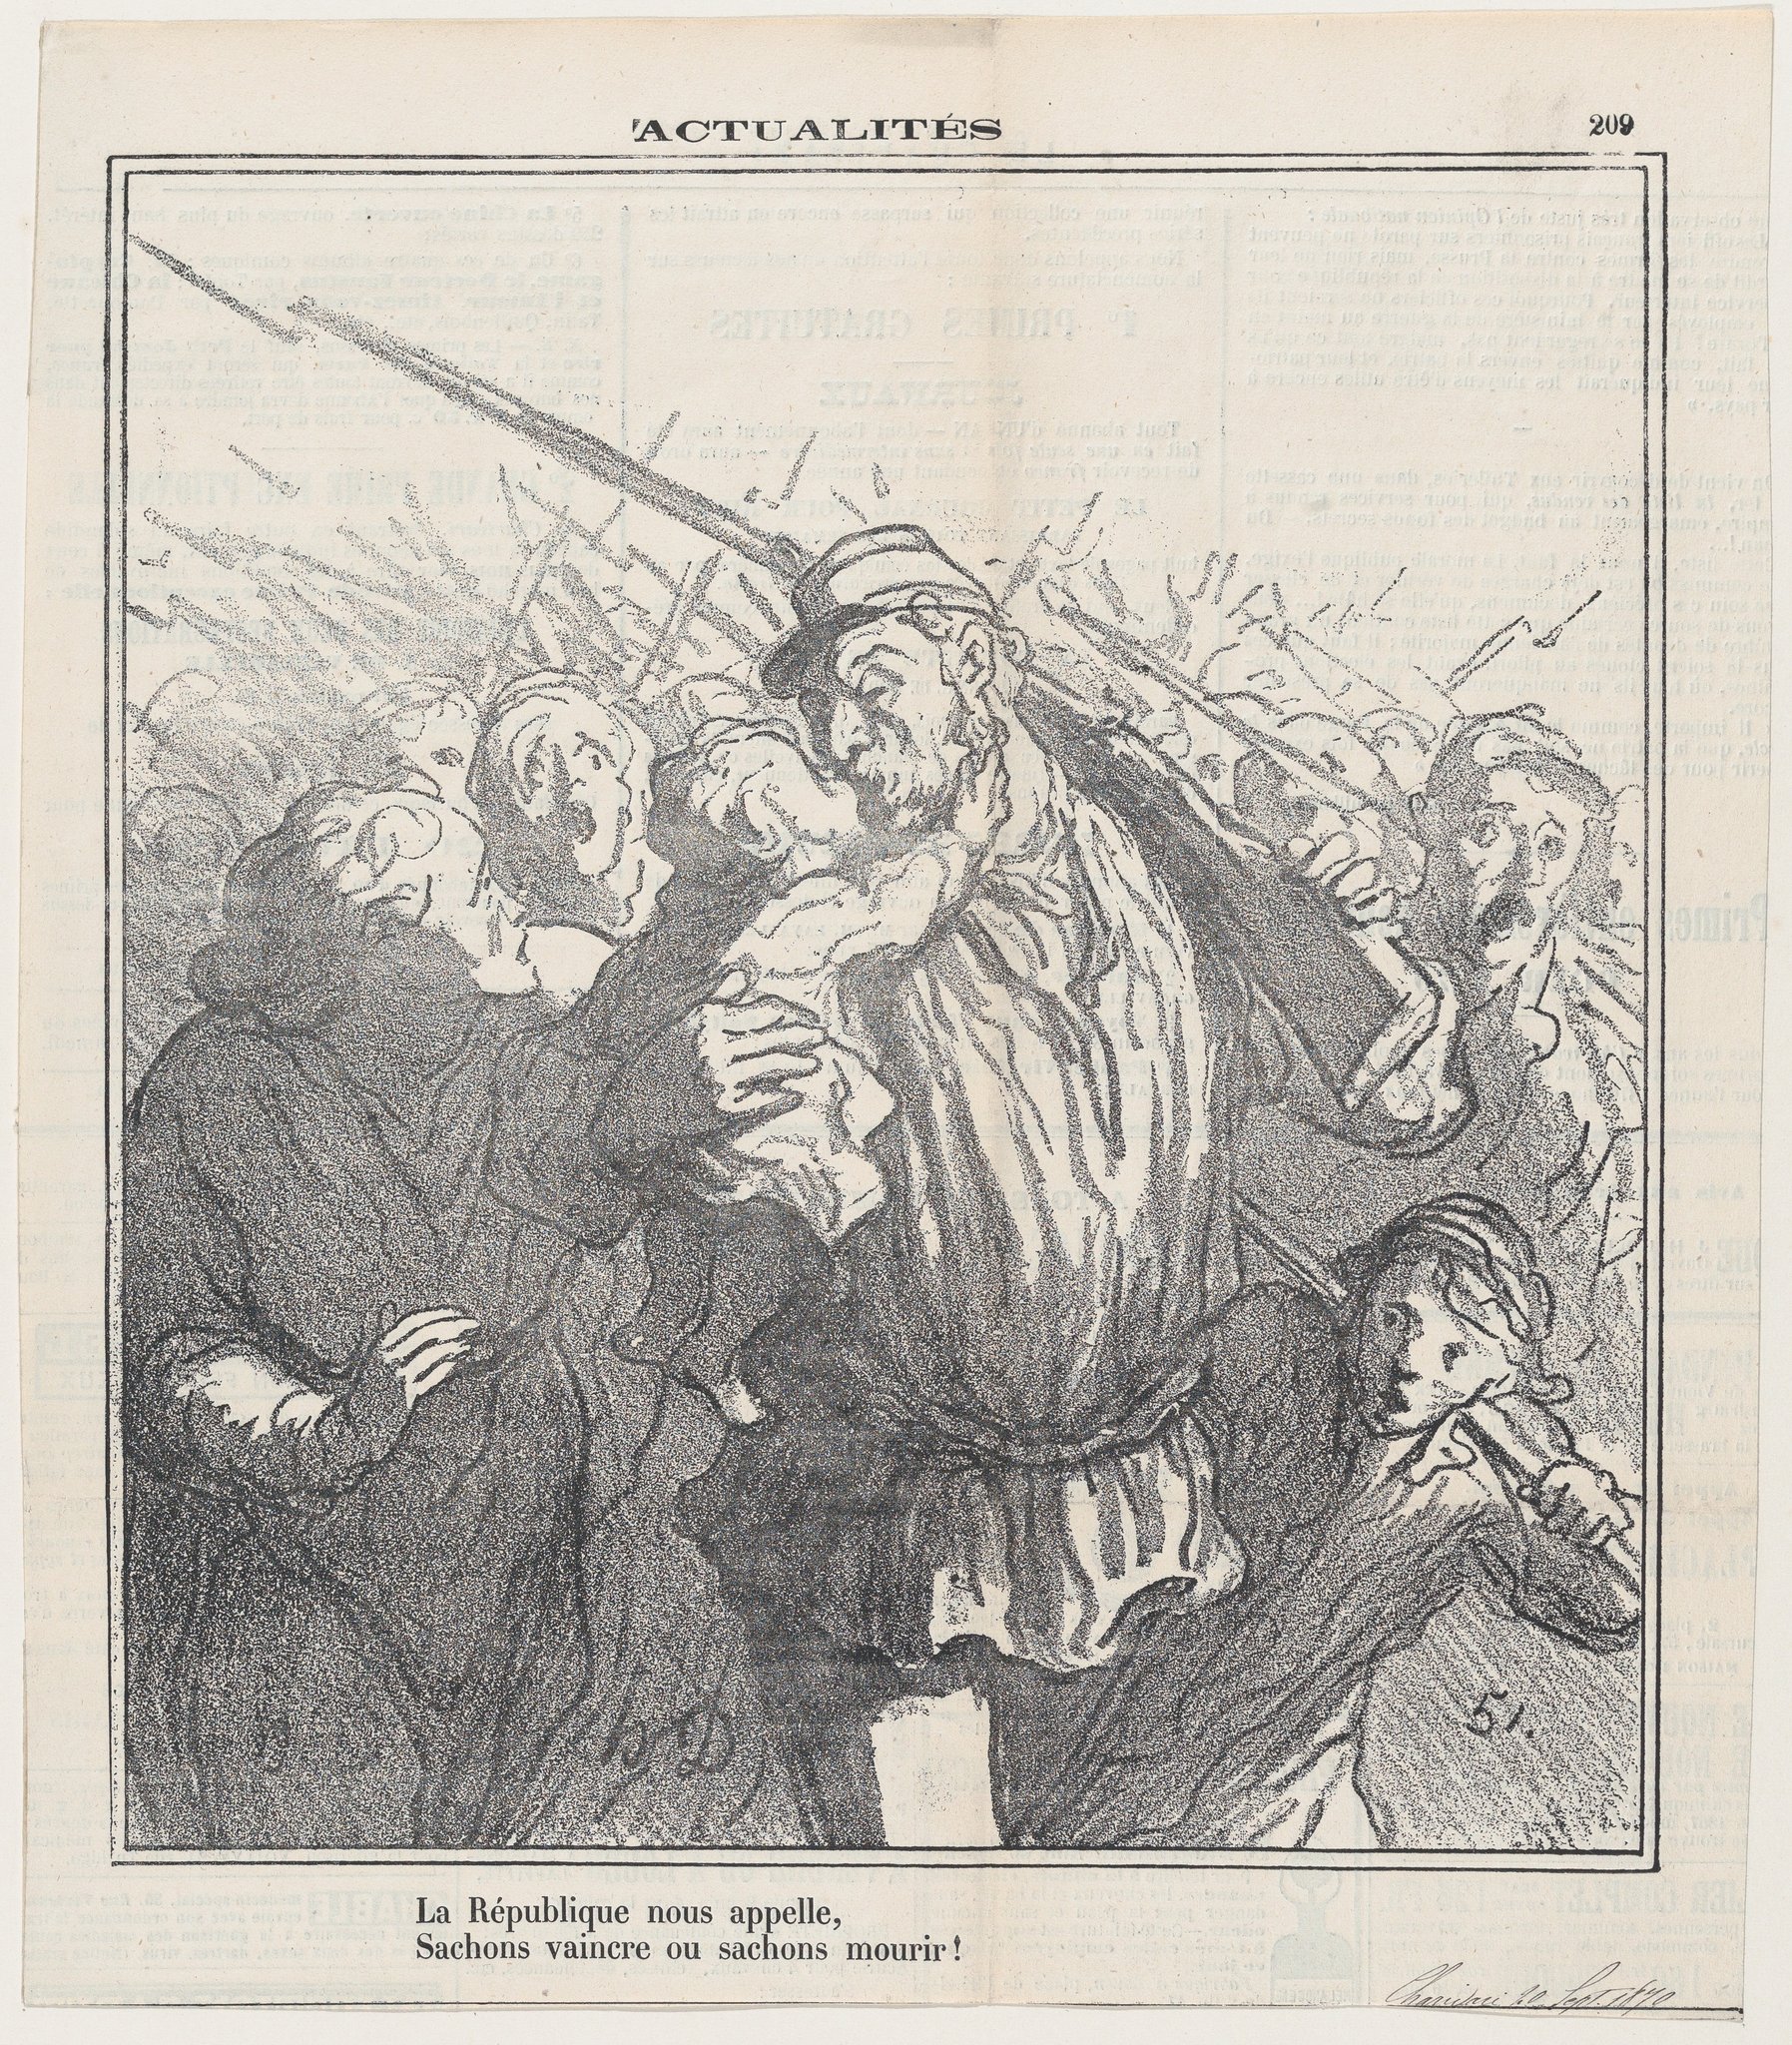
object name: print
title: The Republic calls us! Let us be victorious or die, from 'News of the day,' published in Le Charivari, September 20, 1870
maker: honoré daumier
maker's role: artist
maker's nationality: french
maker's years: 1808-1879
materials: paper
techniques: lithograph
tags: satire,children,men,women